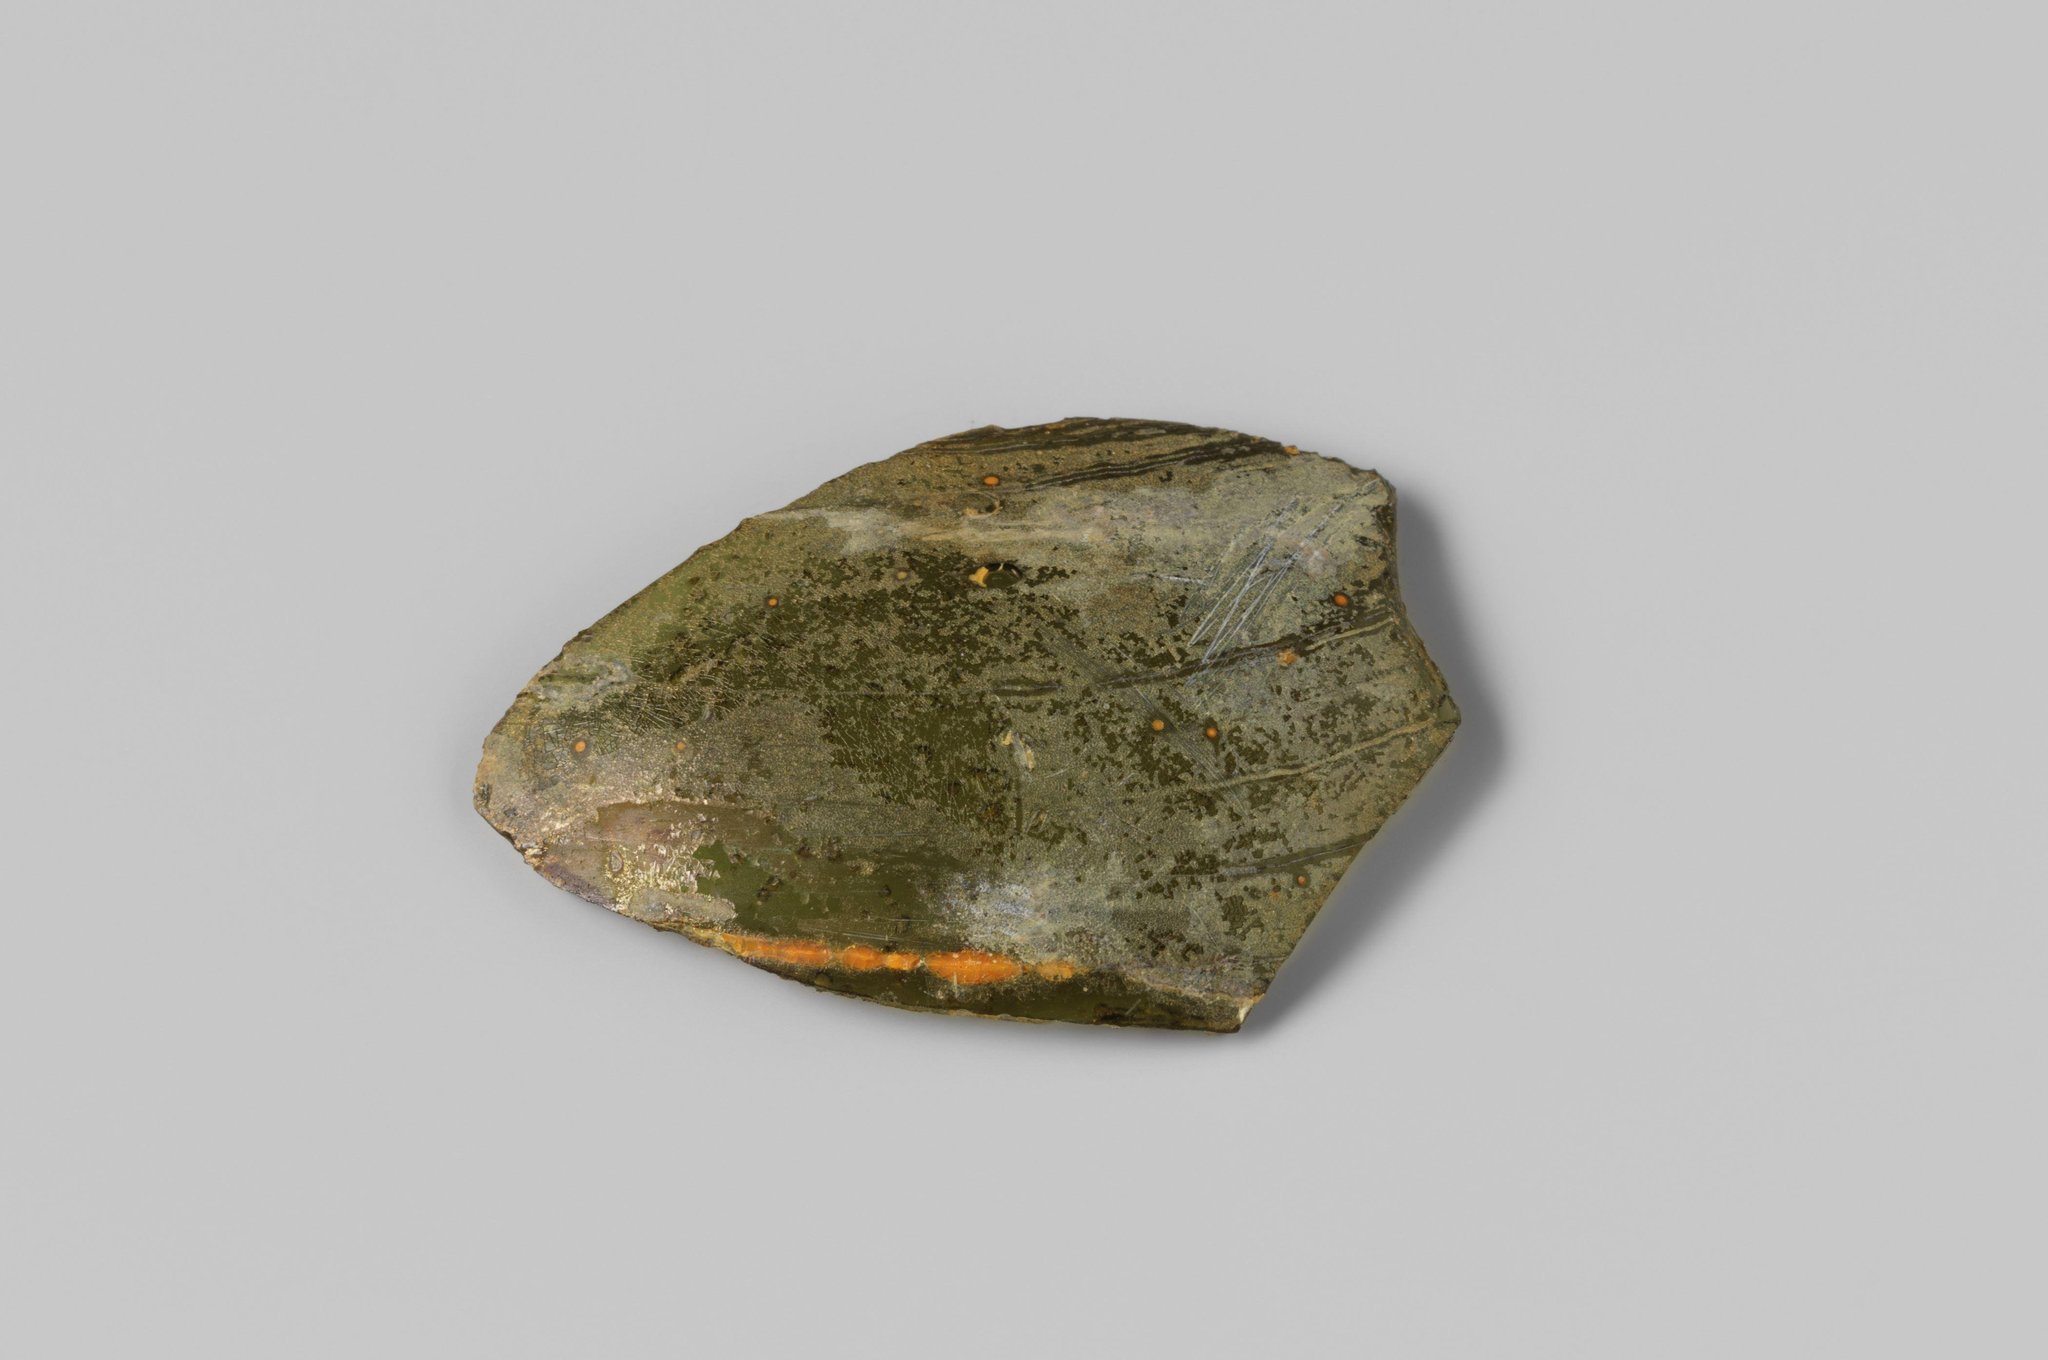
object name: wine bottle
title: Fragment van wijnfles uit het wrak van de in 1735 vergane Oost-Indiëvaarder 't Vliegend Hart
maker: Anonymous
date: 1700-1735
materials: glass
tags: 't vliegend hart (schip), verenigde oostindische compagnie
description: Groen glasfragment, maakte deel uit van een wijnfles. Bolle scherf; de holle kant heeft een blazige structuur, de bolle kant heeft een glad oppervlak en is dof van kleur. Bottle.